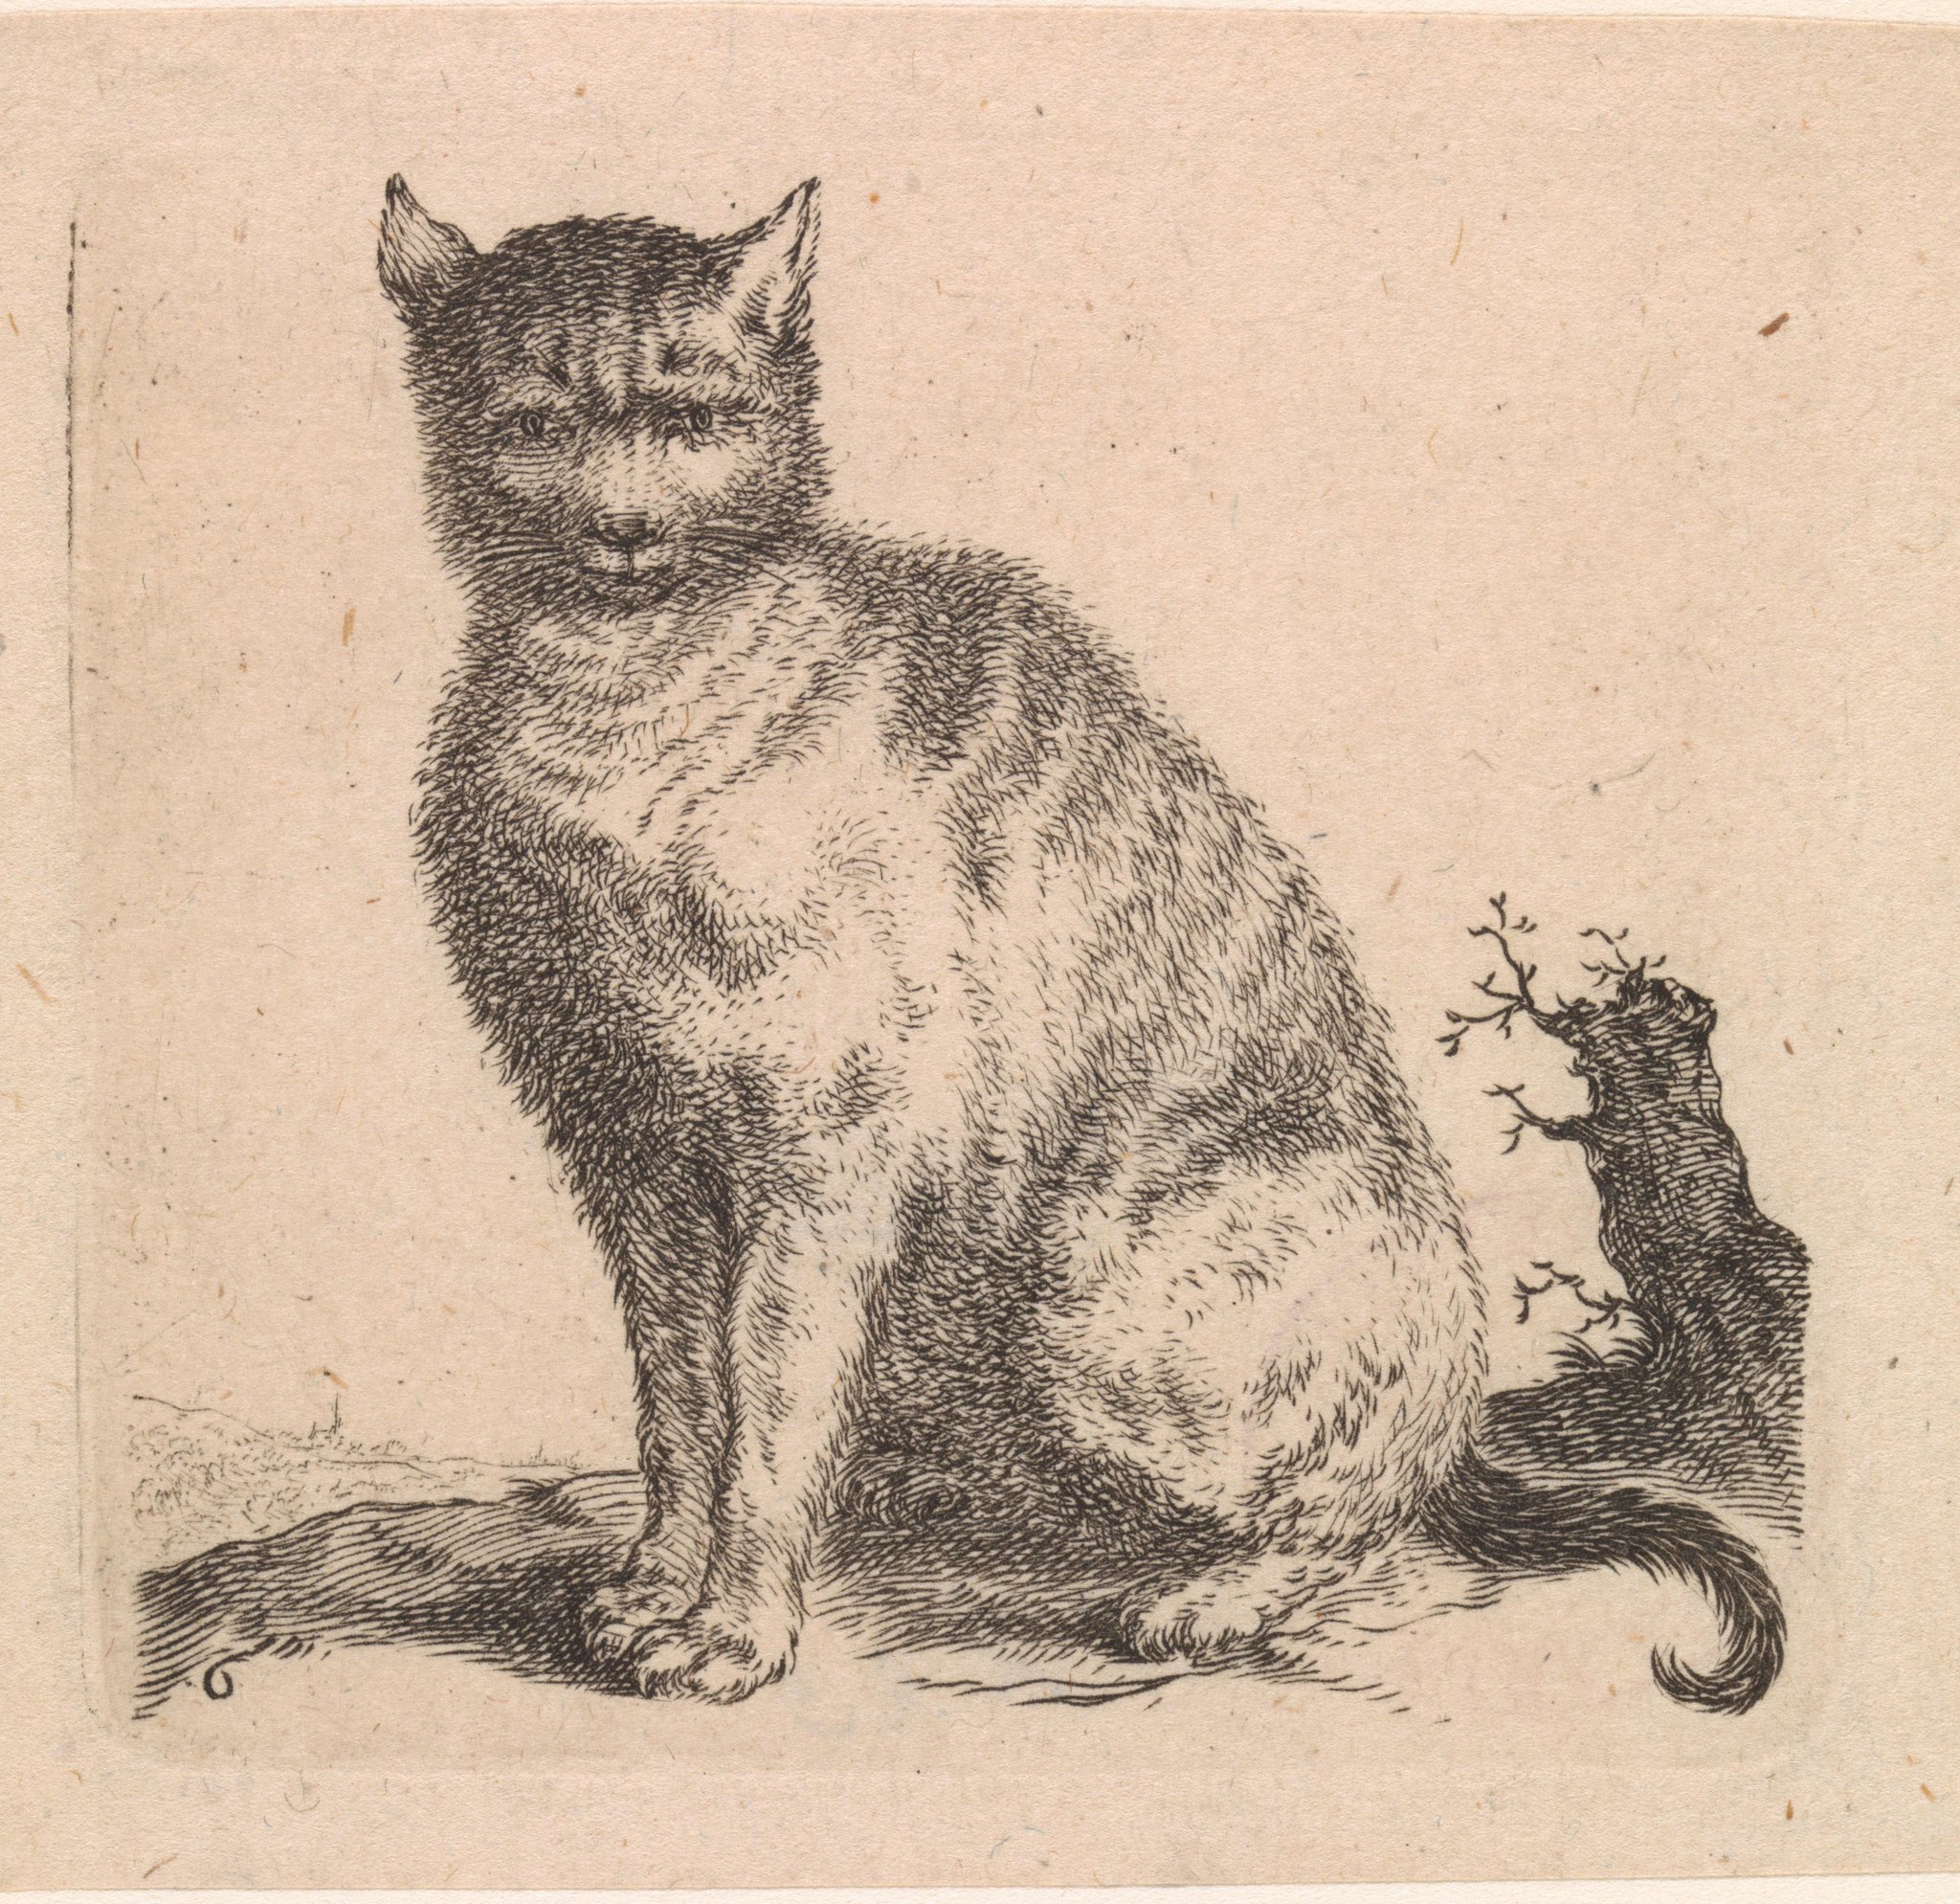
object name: print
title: Boerderij beesten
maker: cornelis saftleven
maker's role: draughtsman, painter, print maker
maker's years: 1607-1681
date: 1617-1681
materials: paper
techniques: etching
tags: cat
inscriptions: collector's mark: Lugt 240